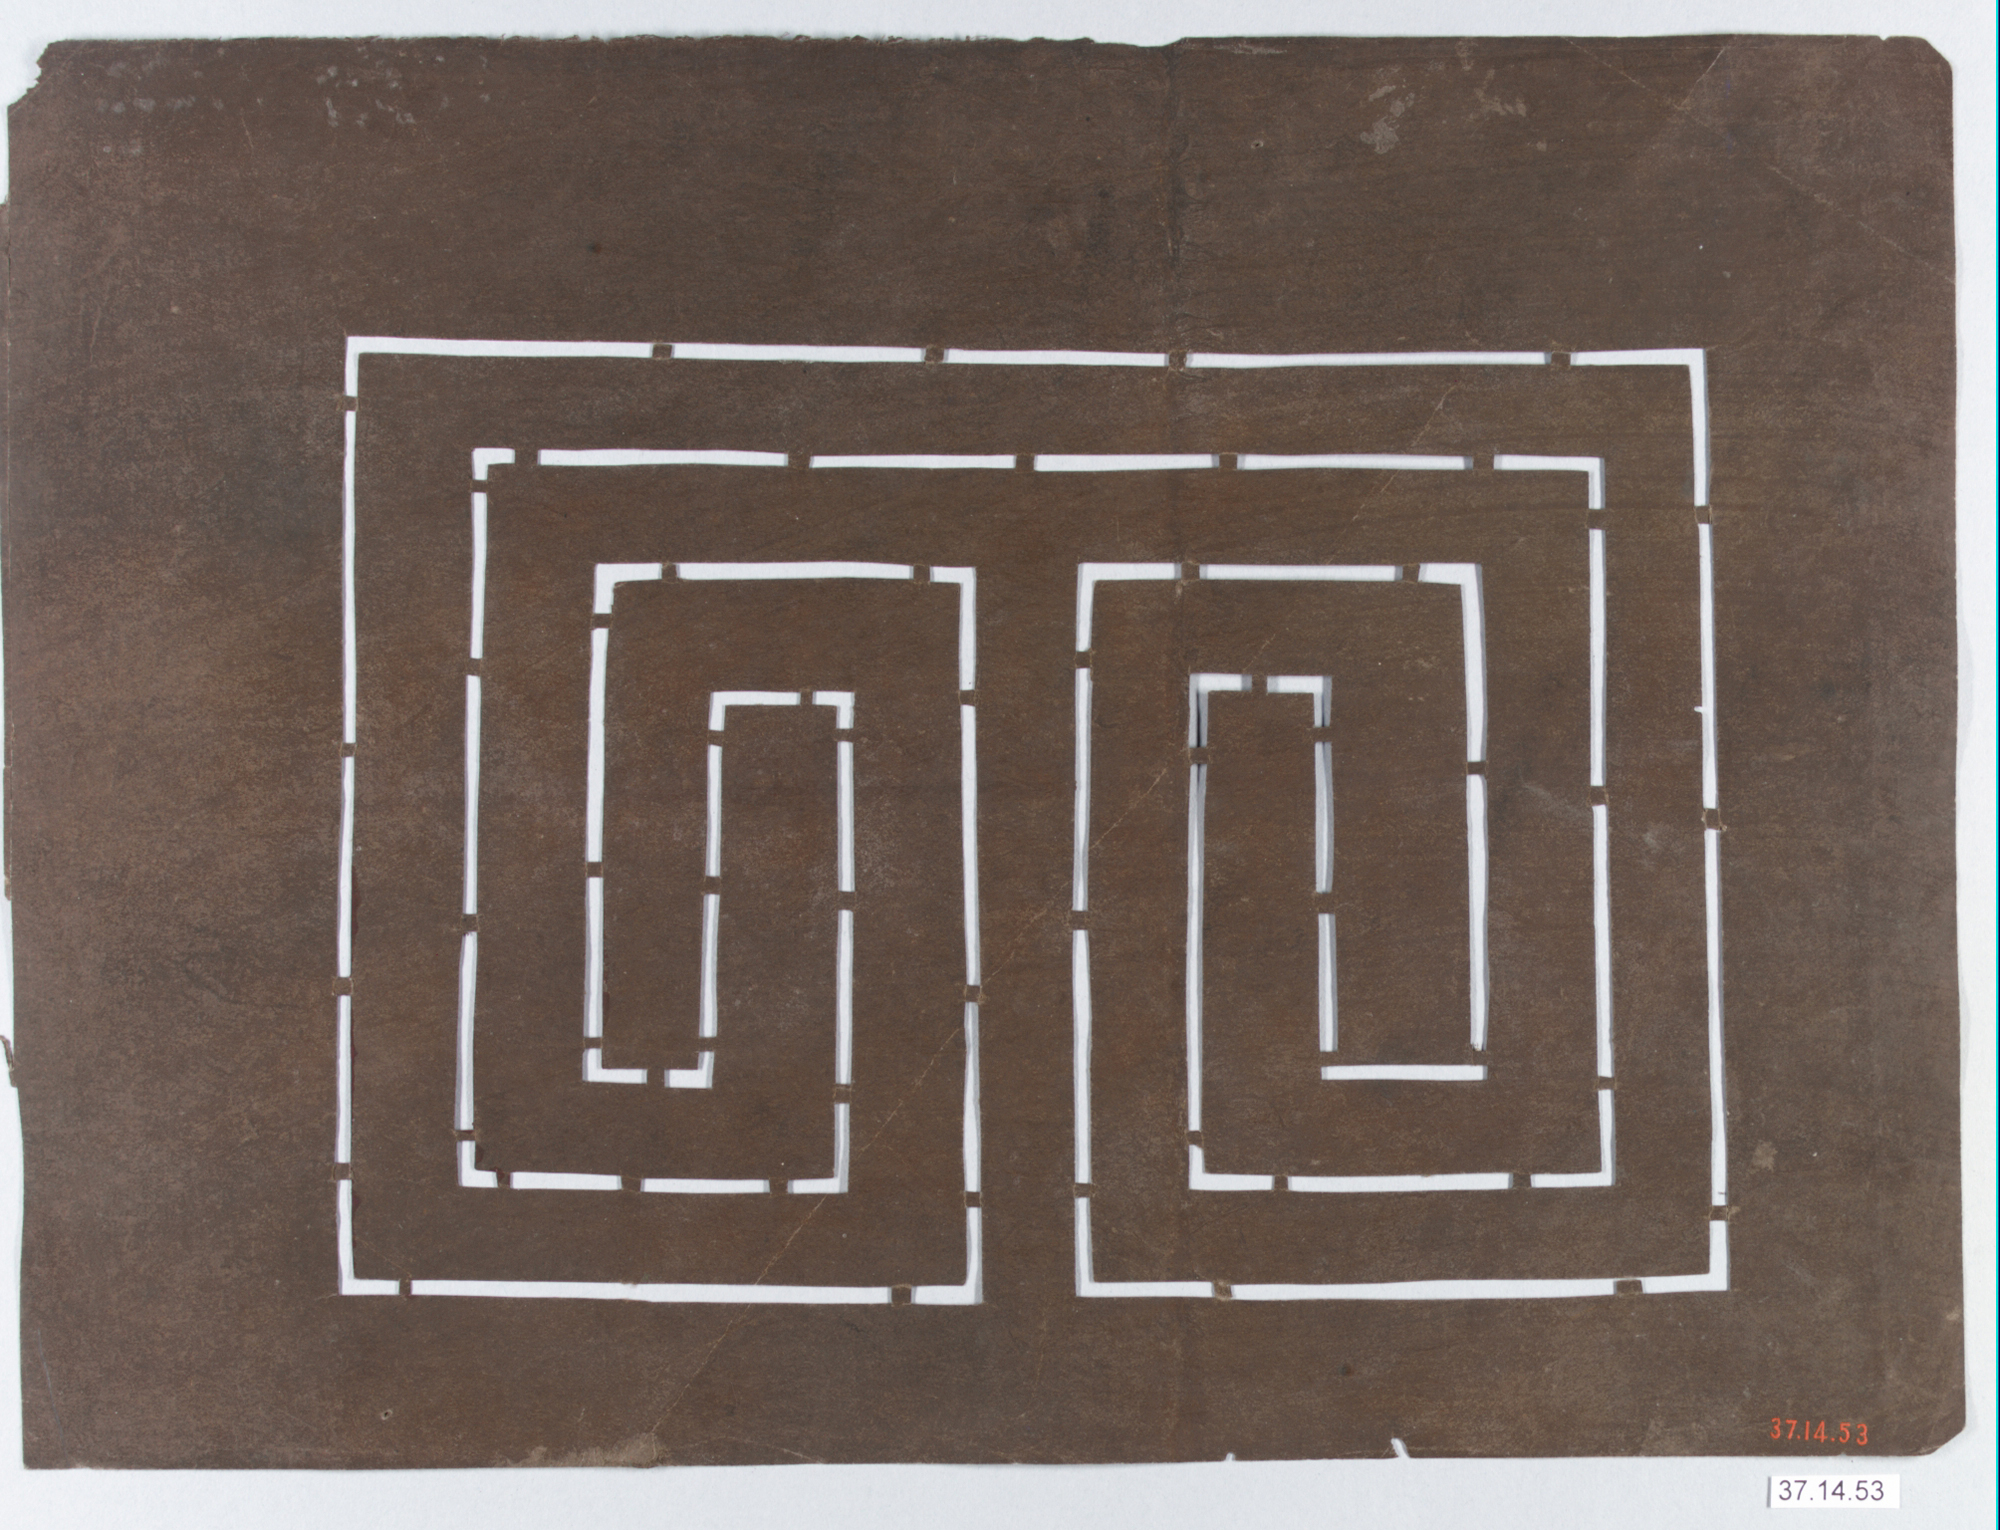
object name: stencil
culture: japanese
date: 1801-1833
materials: paper